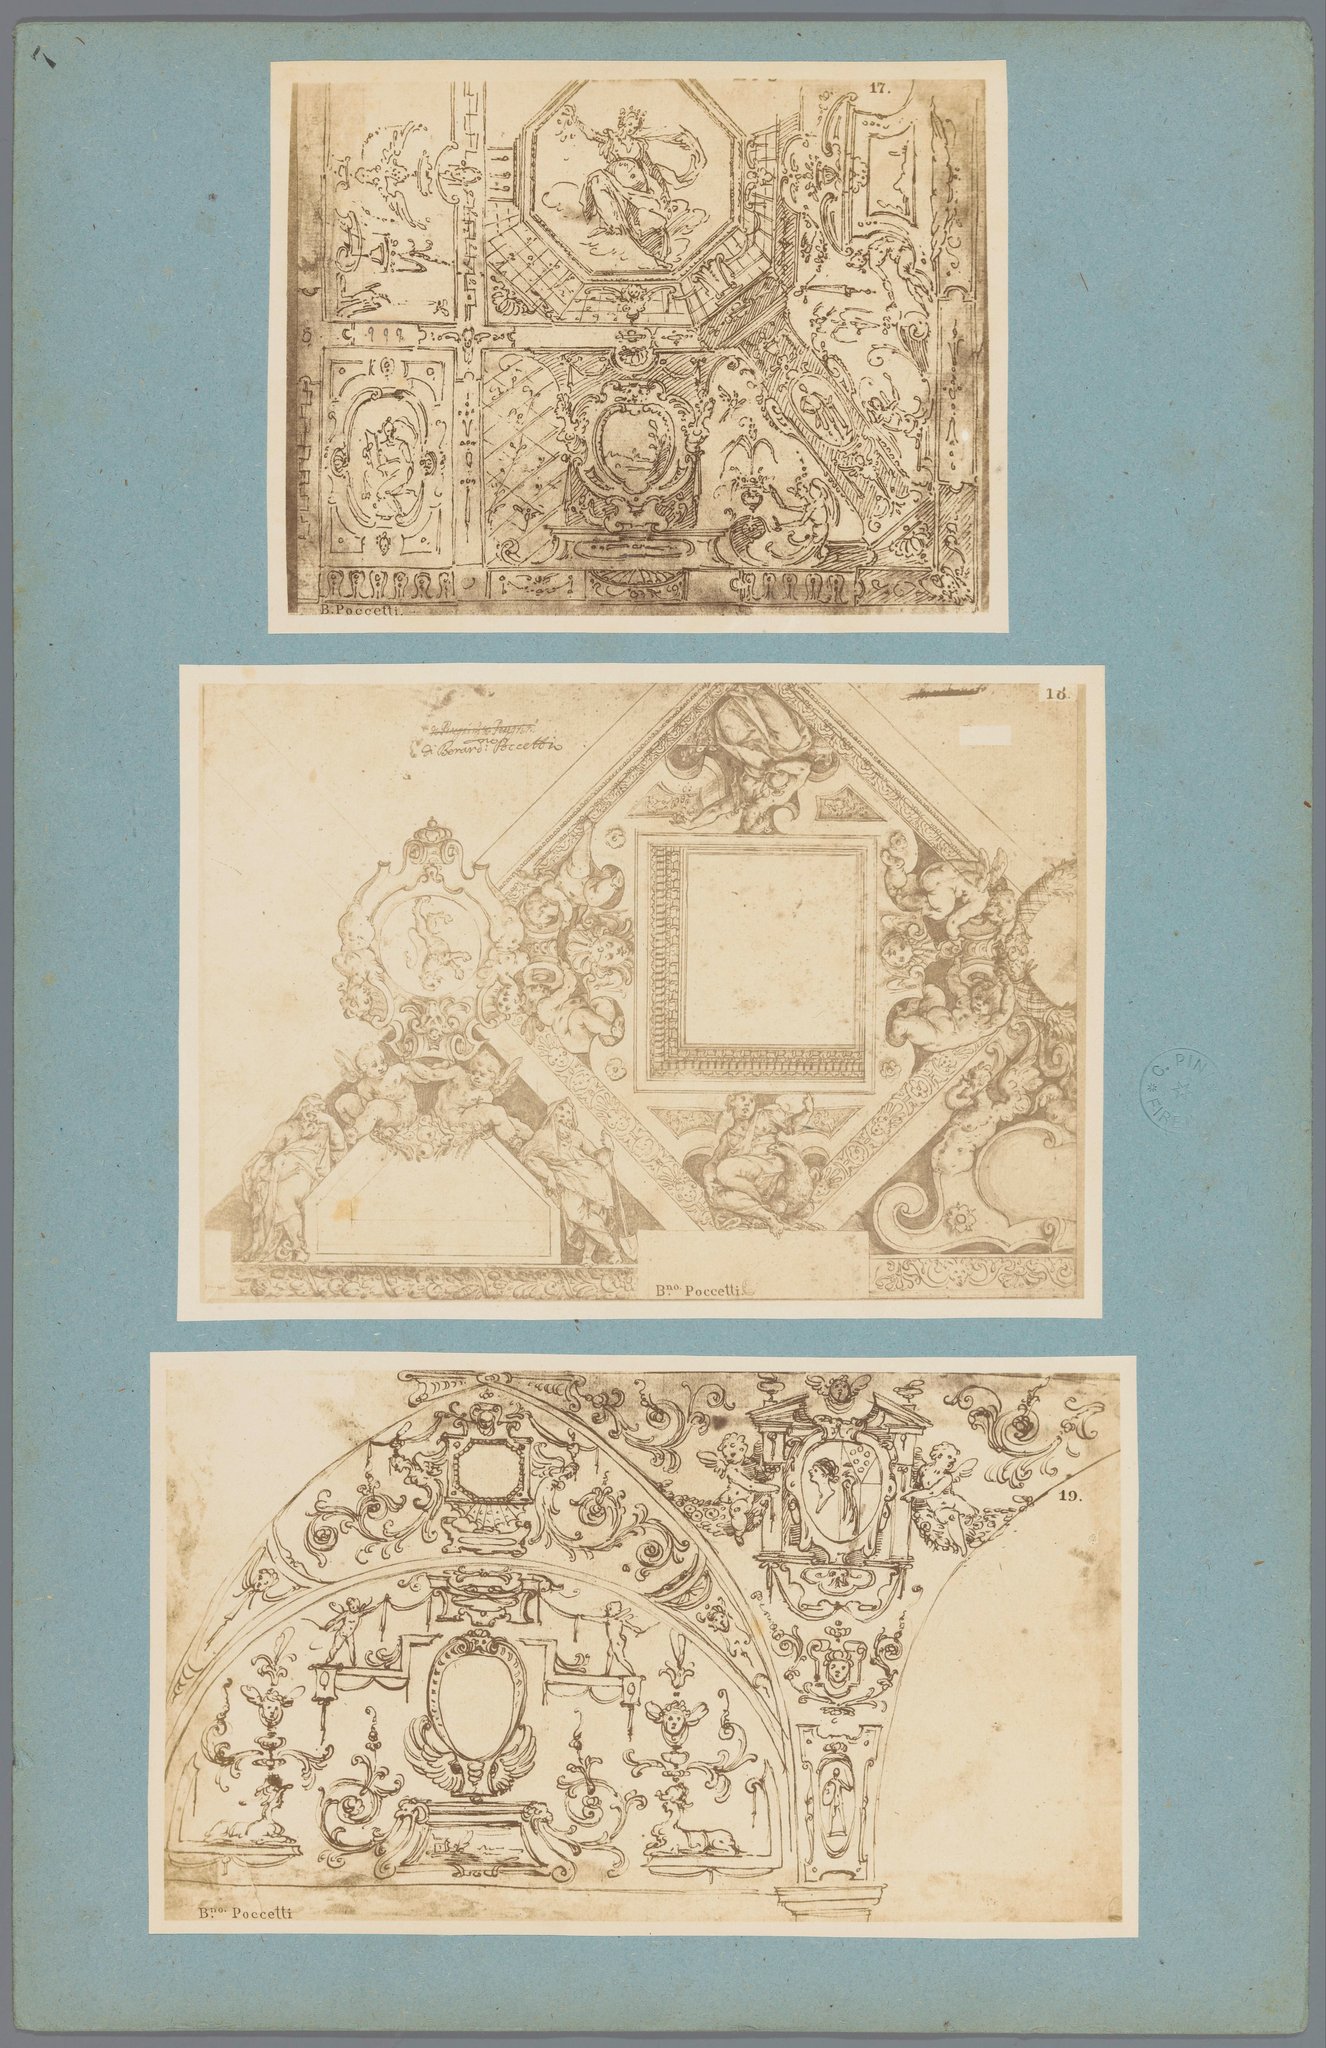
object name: photograph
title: Drie fotoreproducties van tekeningen van plafonddecoraties door Bernardino Poccetti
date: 1875-1900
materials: cardboard, photographic support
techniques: albumen print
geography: europe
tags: drawing, sketch, (decorated) ceiling, cupids: 'amores', 'amoretti', 'putti', europe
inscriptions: number: ‘19.’, name: ‘C. Pini Firenze’, number: ‘18.’, number: ‘7[...]’, collector's mark: Lugt 3937, number: ‘17.’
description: Boven (17) een plafonddecoratie met een godin centraal, midden (18) een plafonddecoratie met putti en een wapenschild, onder (19) een plafonddecoratie met cartouches en putti.